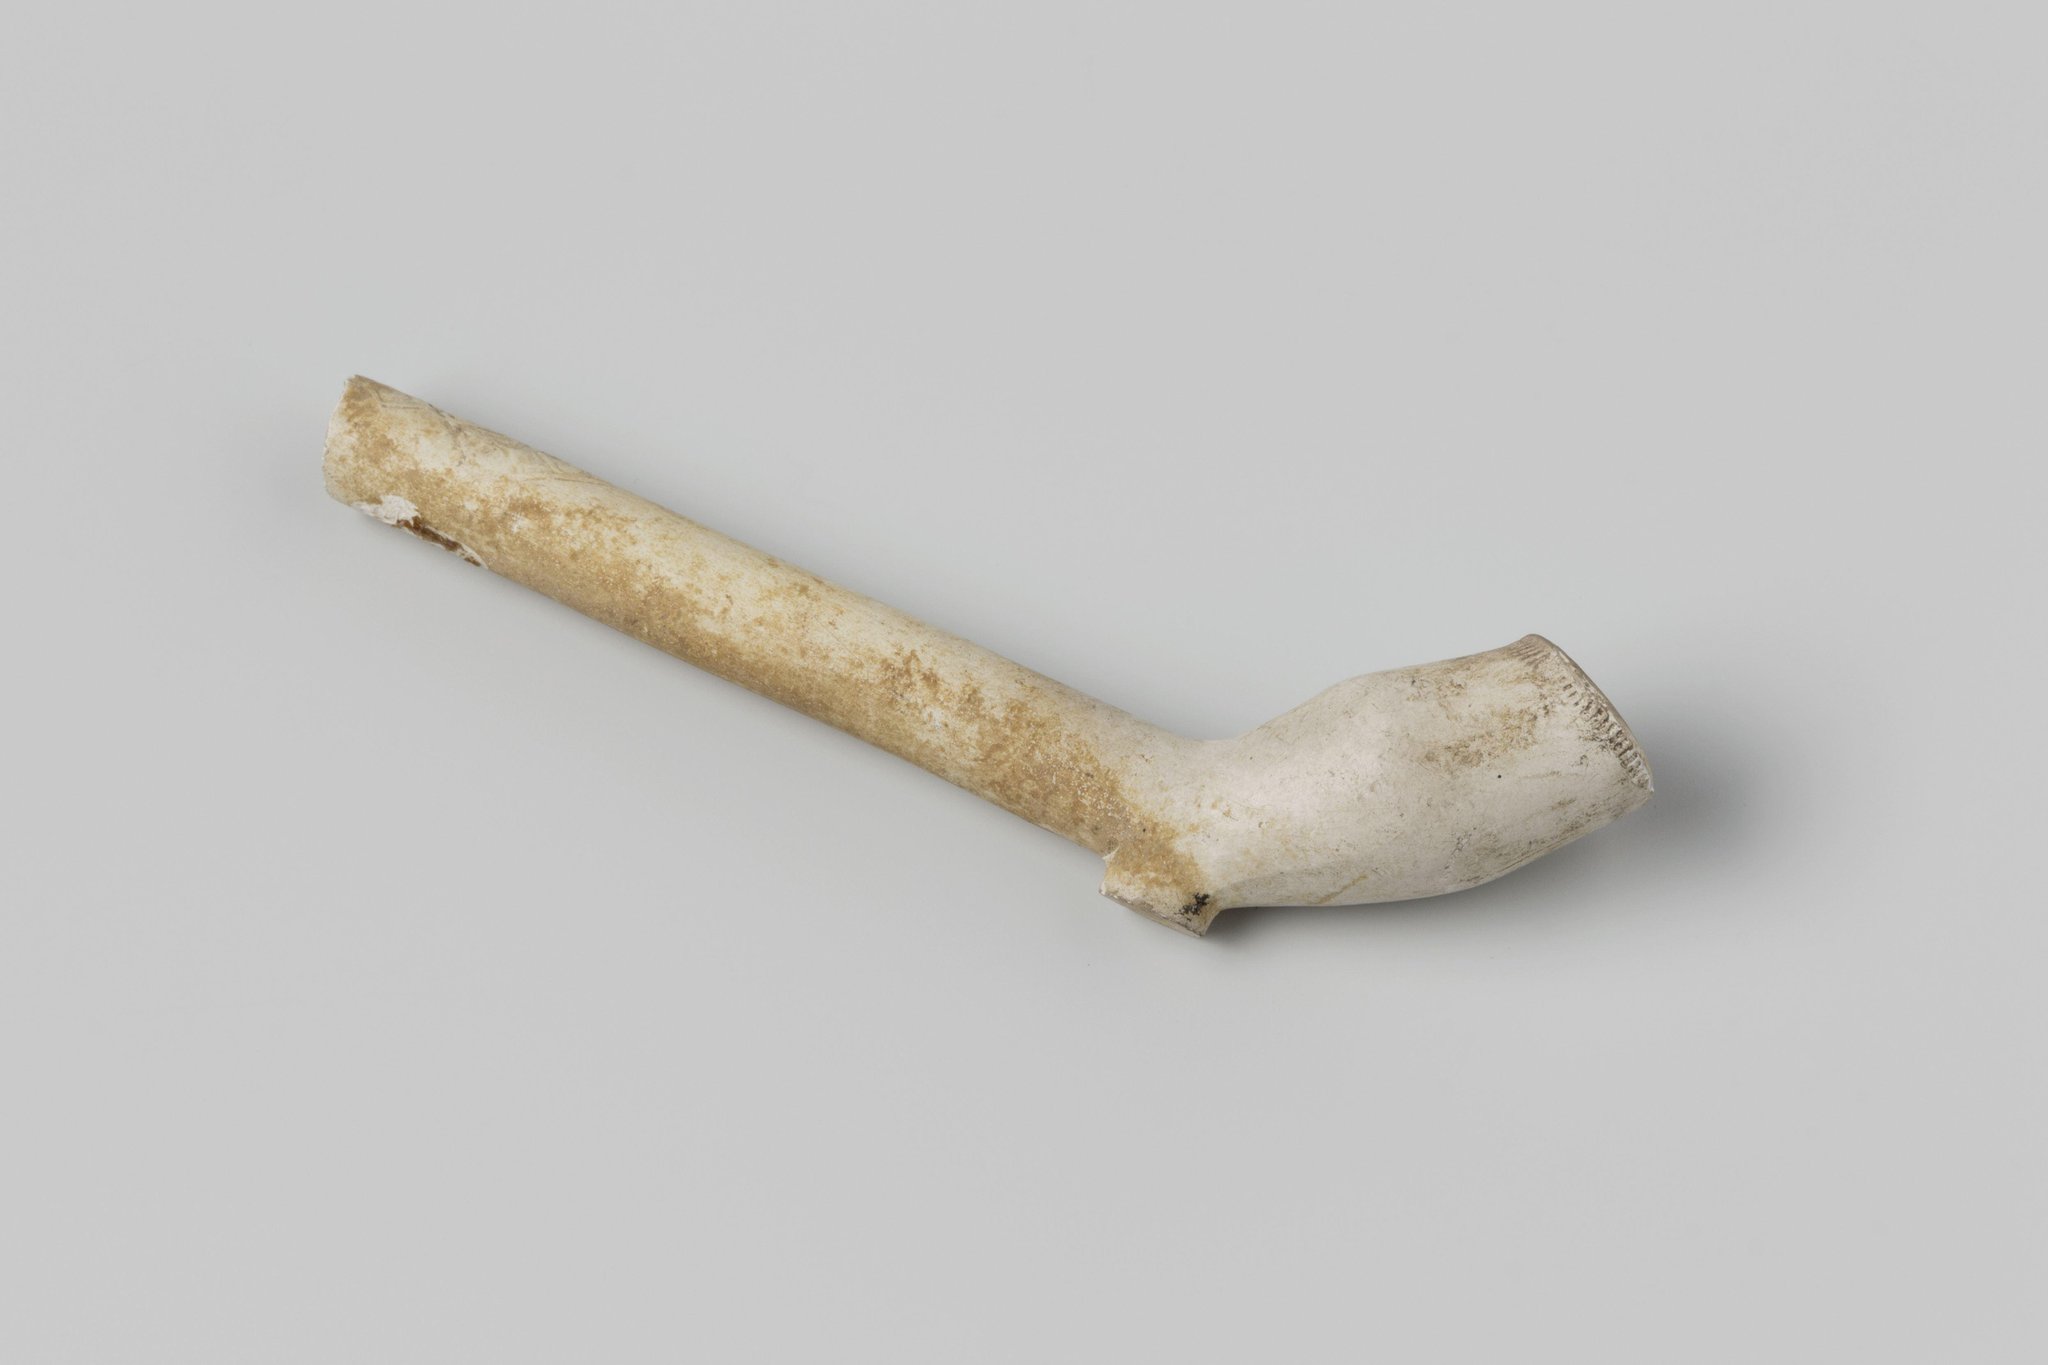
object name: pipe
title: Pijp van witte aarde met losangefiguren met daarin lelies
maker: Anonymous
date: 1400-1950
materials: earthenware, clay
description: Pijp van witte aarde met losangefiguren met daarin lelies.